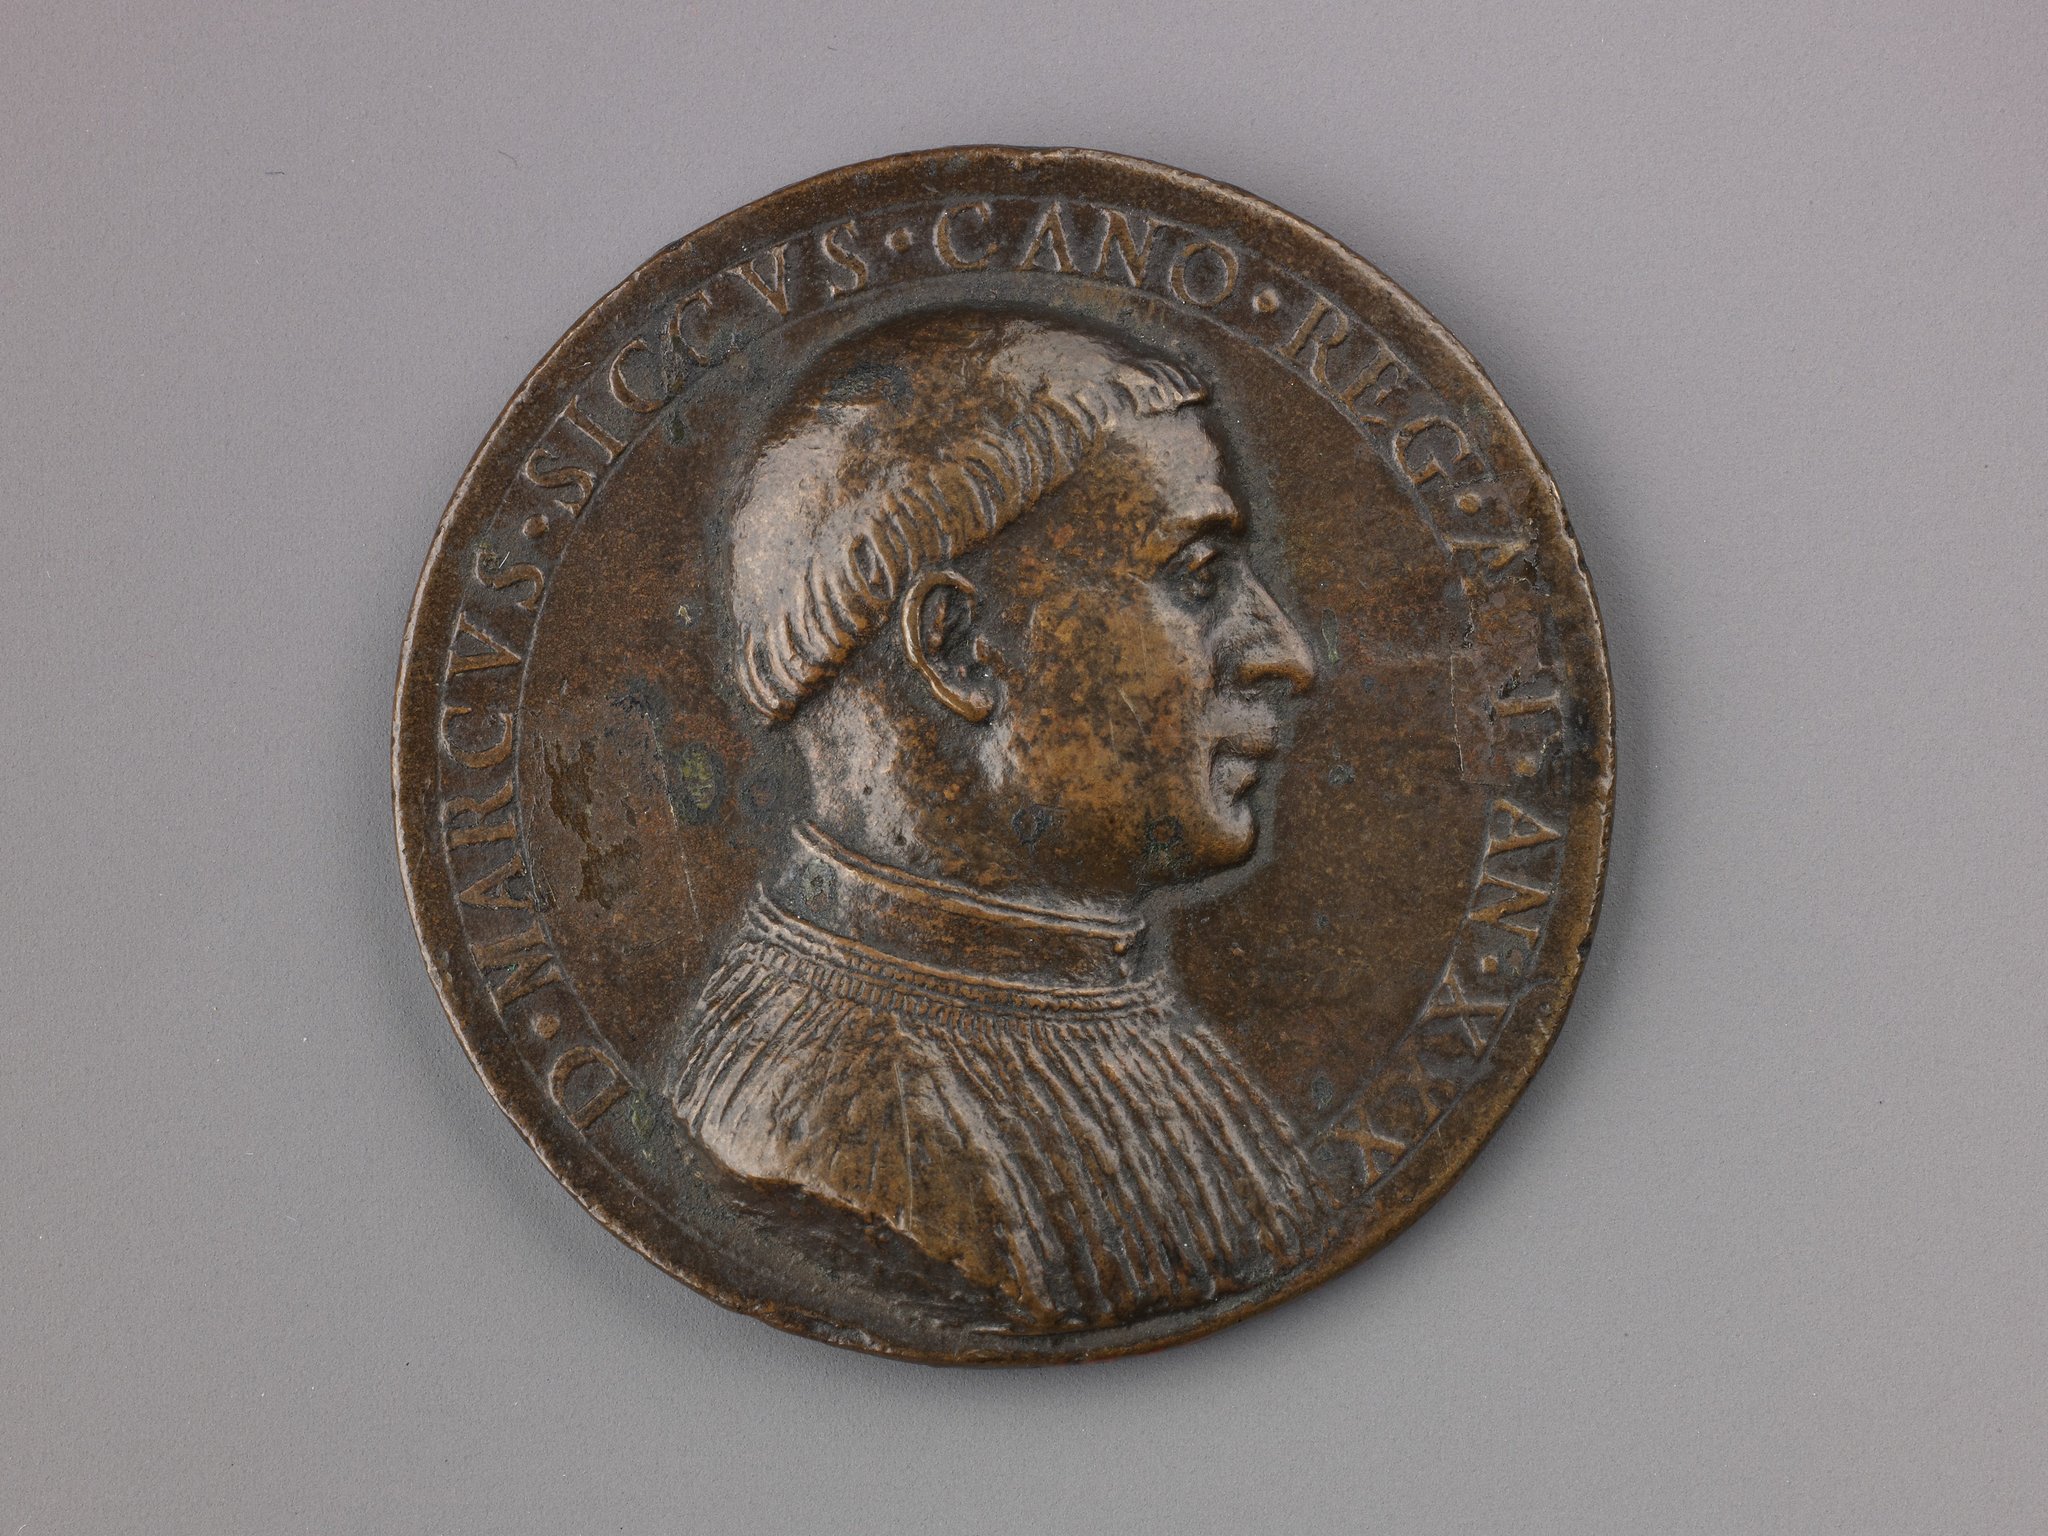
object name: medal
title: Medal: Bust of Marco Sicco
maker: antonio abondio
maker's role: artist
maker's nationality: italian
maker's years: 1538-1591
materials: bronze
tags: men,coat of arms